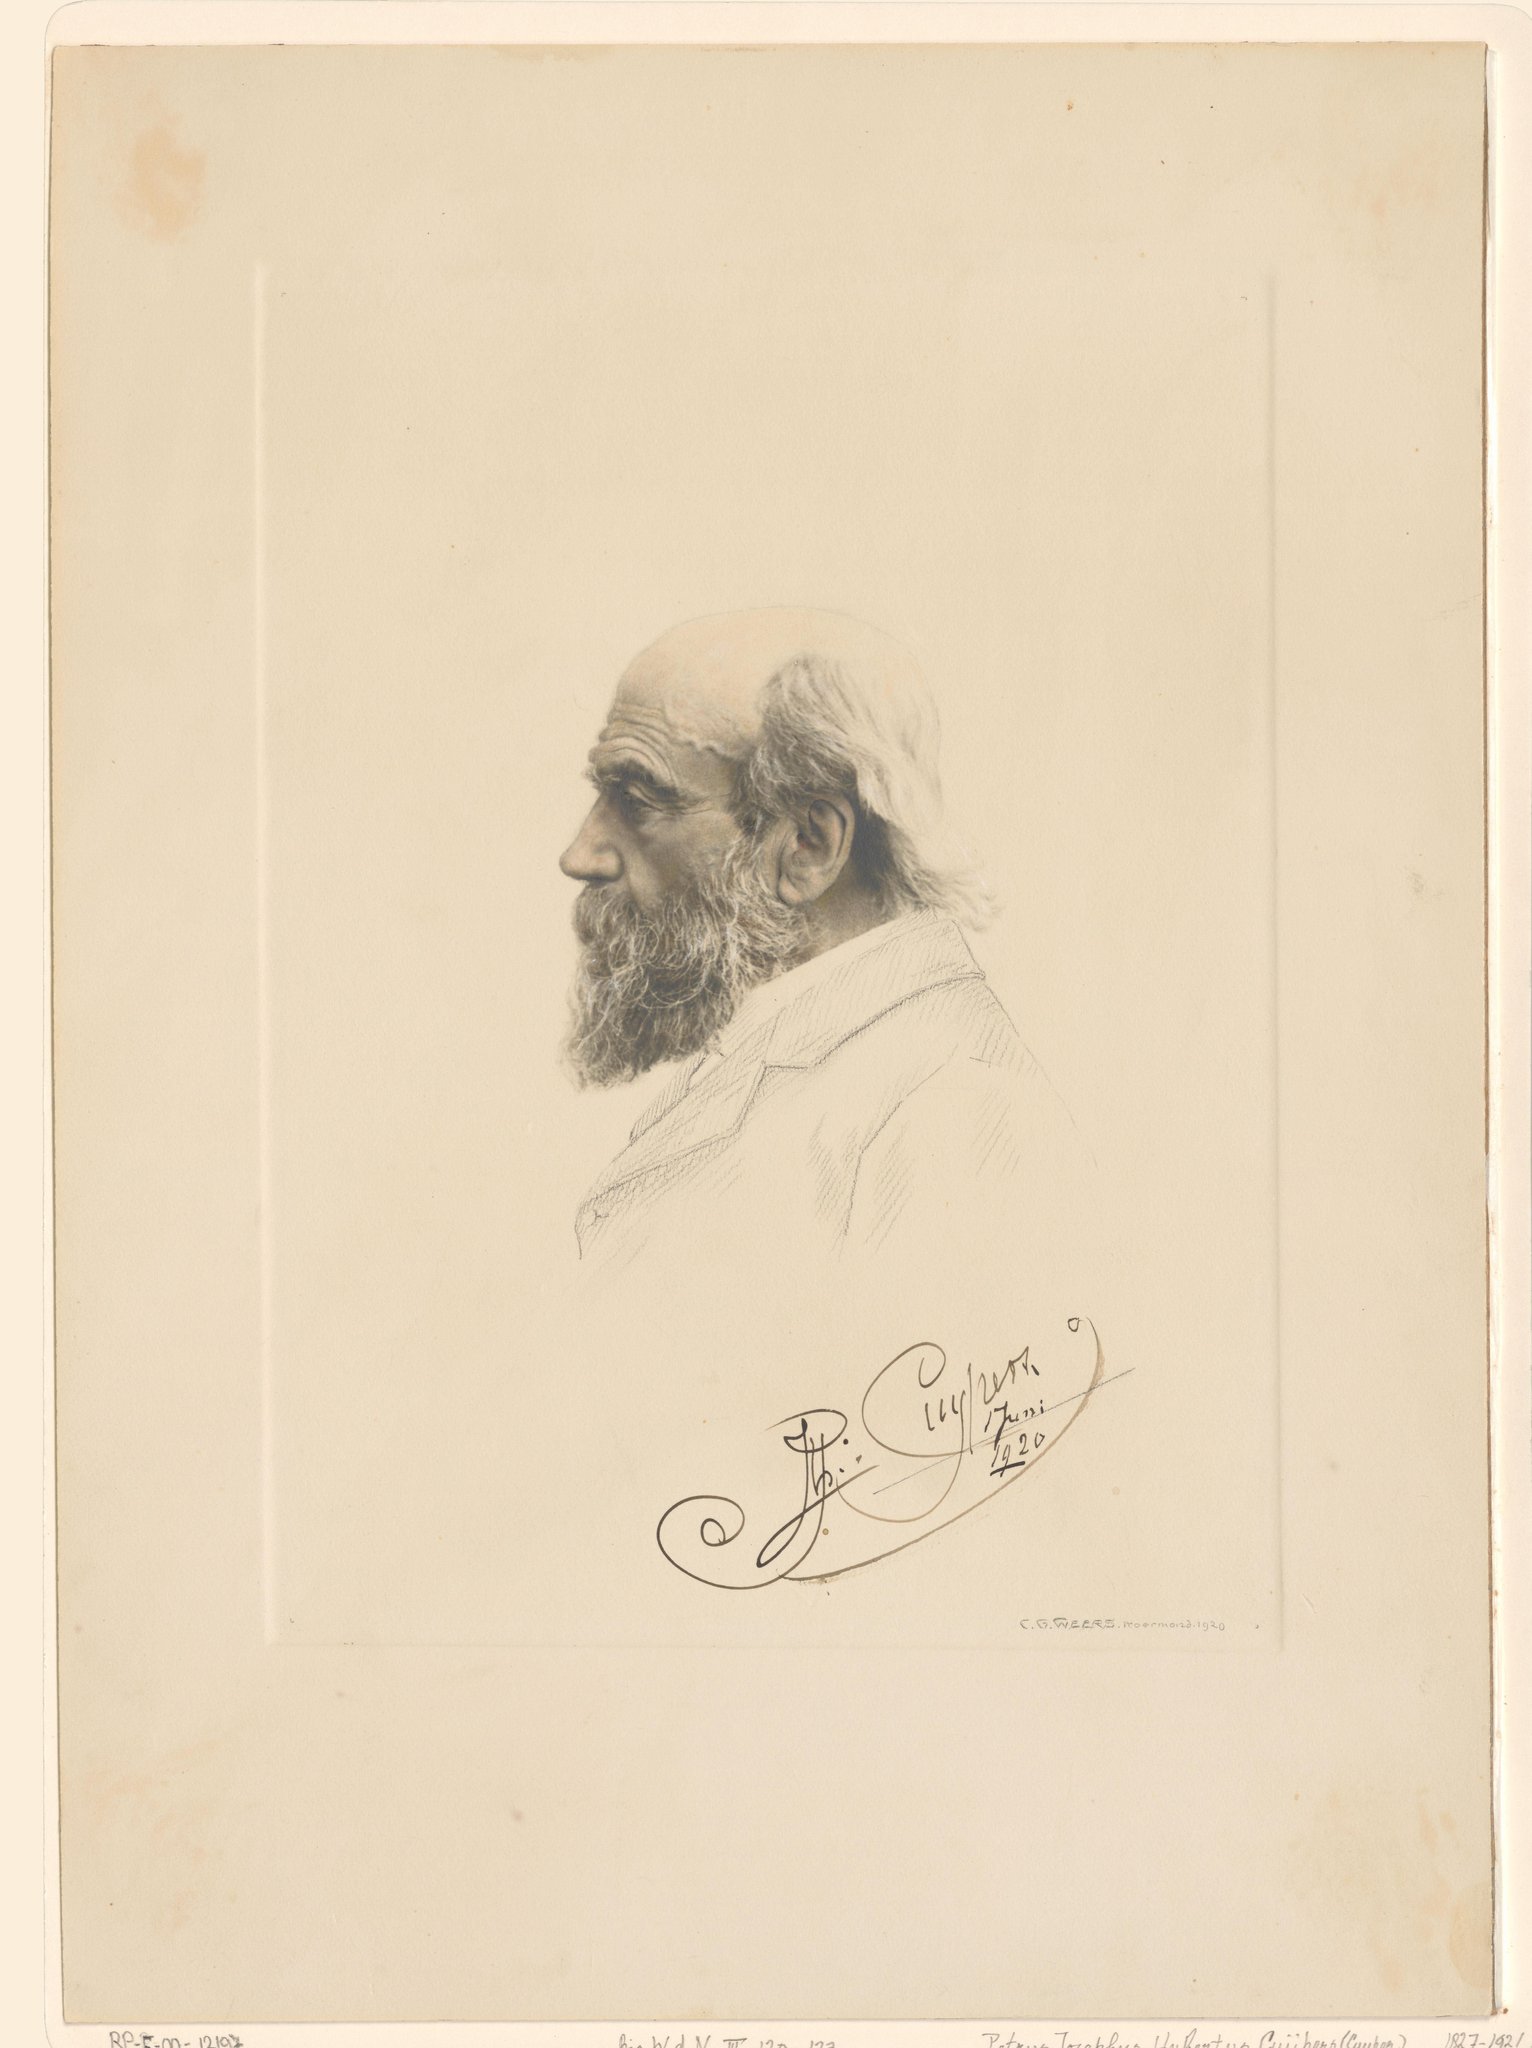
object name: photograph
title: Portret van Pierre Joseph Hubert Cuypers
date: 1920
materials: cardboard, ink, paper, pencil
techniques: hand coloring, pen, photography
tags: draughtsman, pierre joseph hubert cuypers, historical persons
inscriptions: date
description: De foto is gesigneerd door Pierre Joseph Hubert Cuypers.